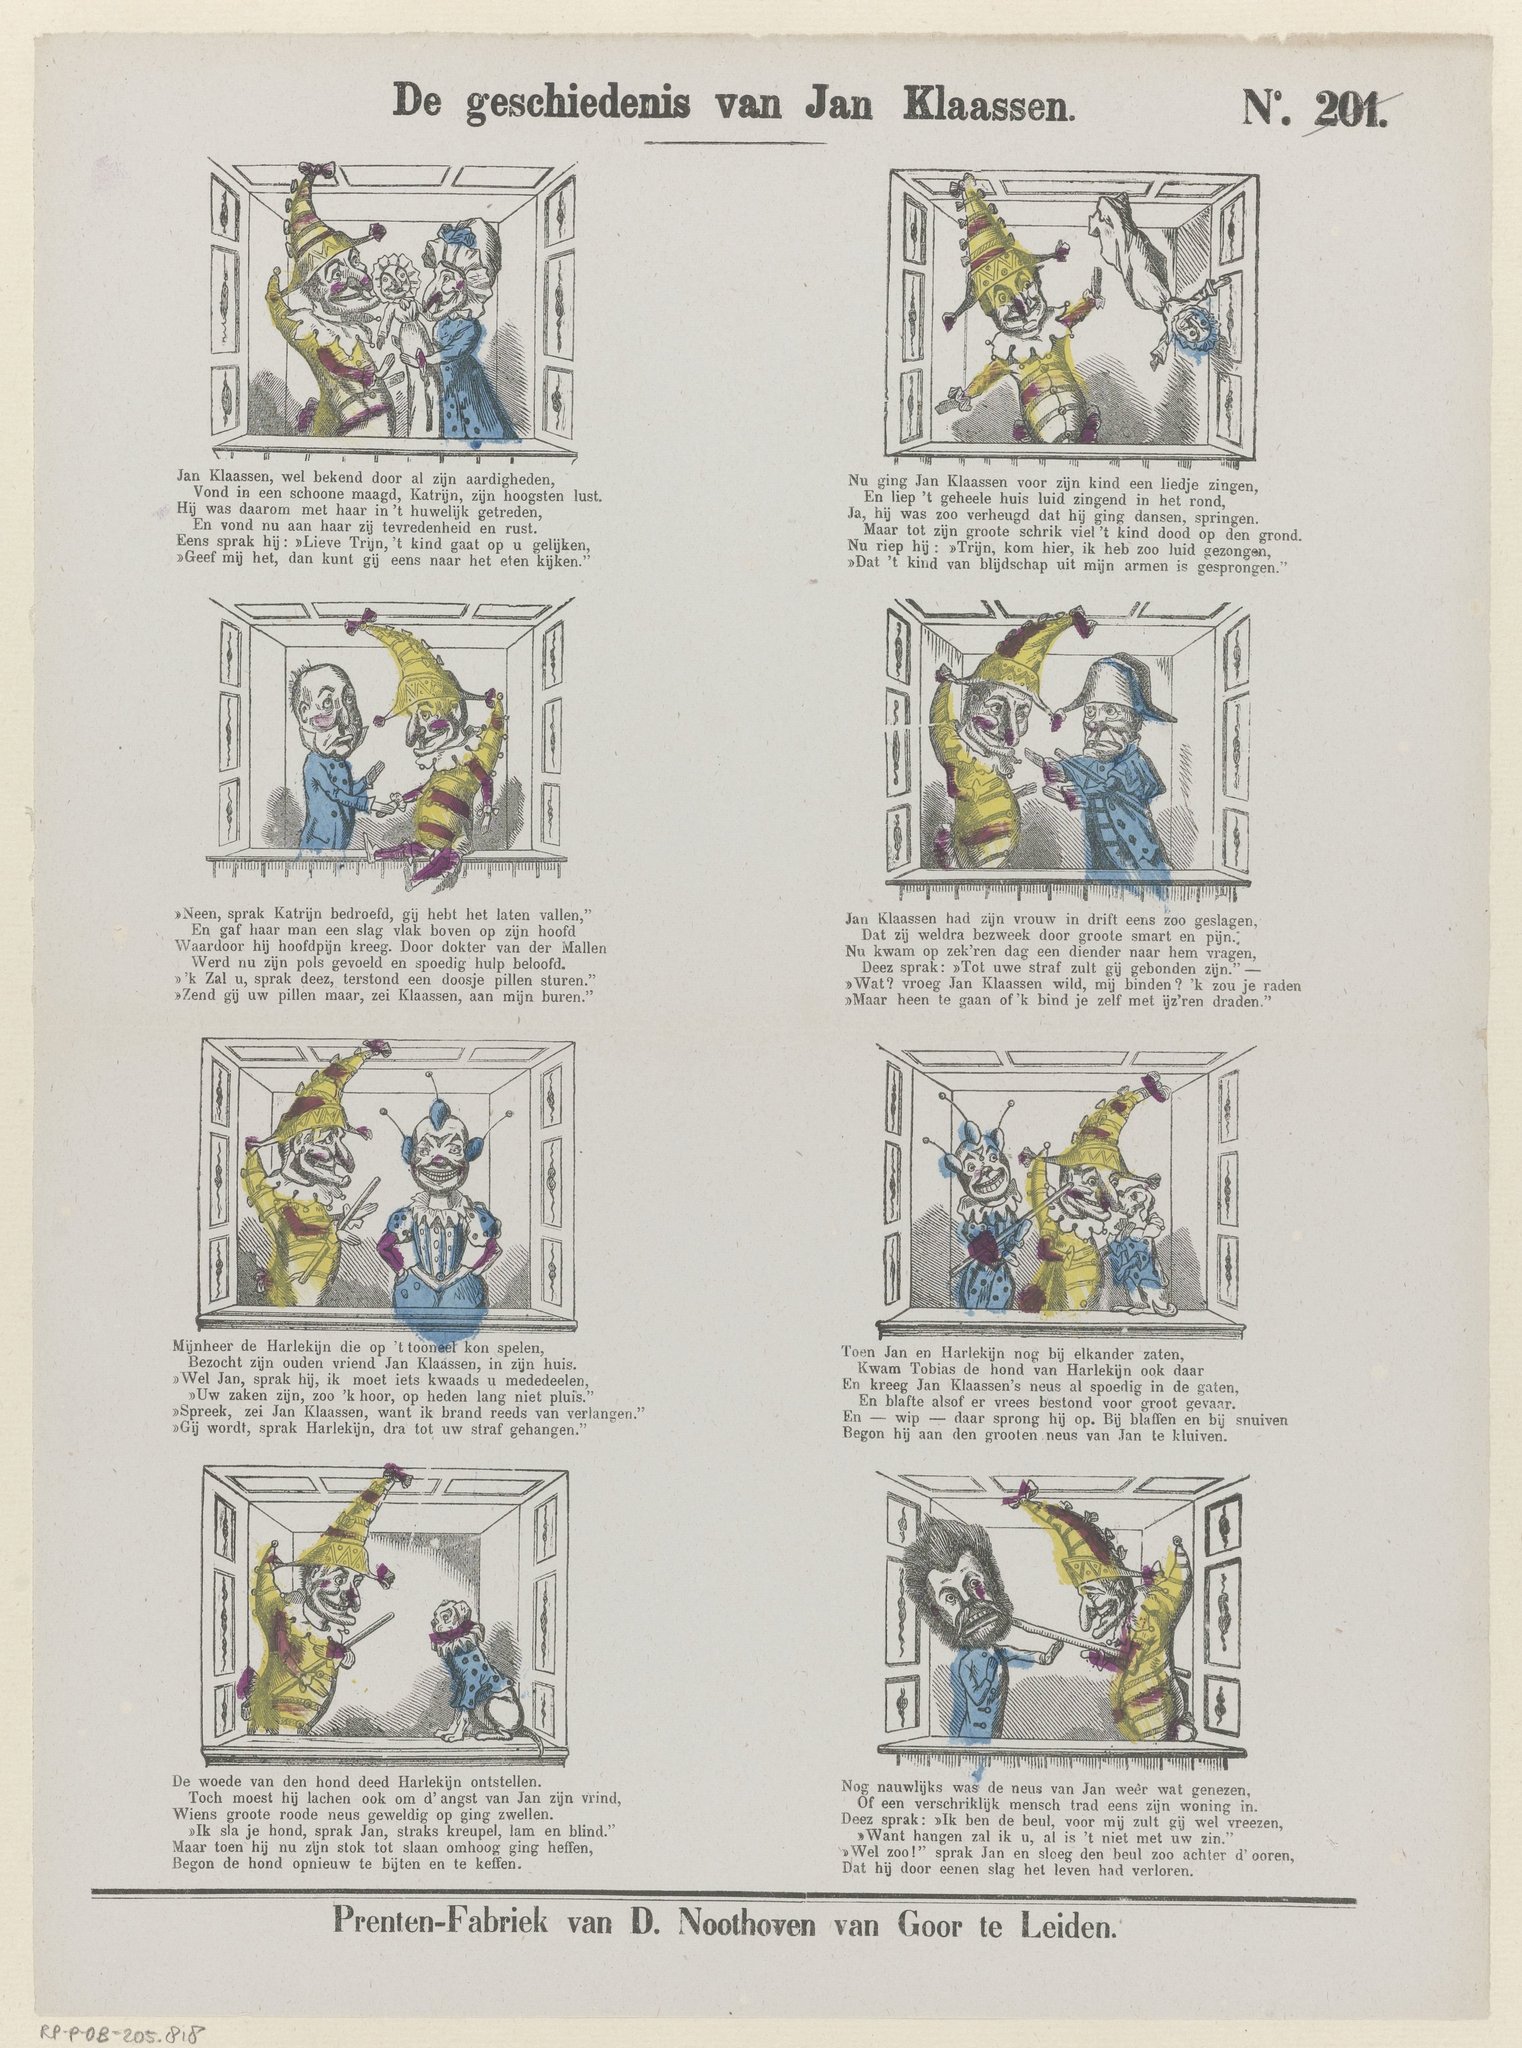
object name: print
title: De geschiedenis van Jan Klaassen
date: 1850-1881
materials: paper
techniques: colour, letterpress printing, engraving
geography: leiden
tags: punch and judy, puppet and marionette show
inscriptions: collector's mark: Lugt 2760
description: Blad met 8 voorstellingen over de poppenkastpop Jan Klaassen. Onder elke voorstelling een zesregelig vers. Genummerd rechtsboven: No. 201.